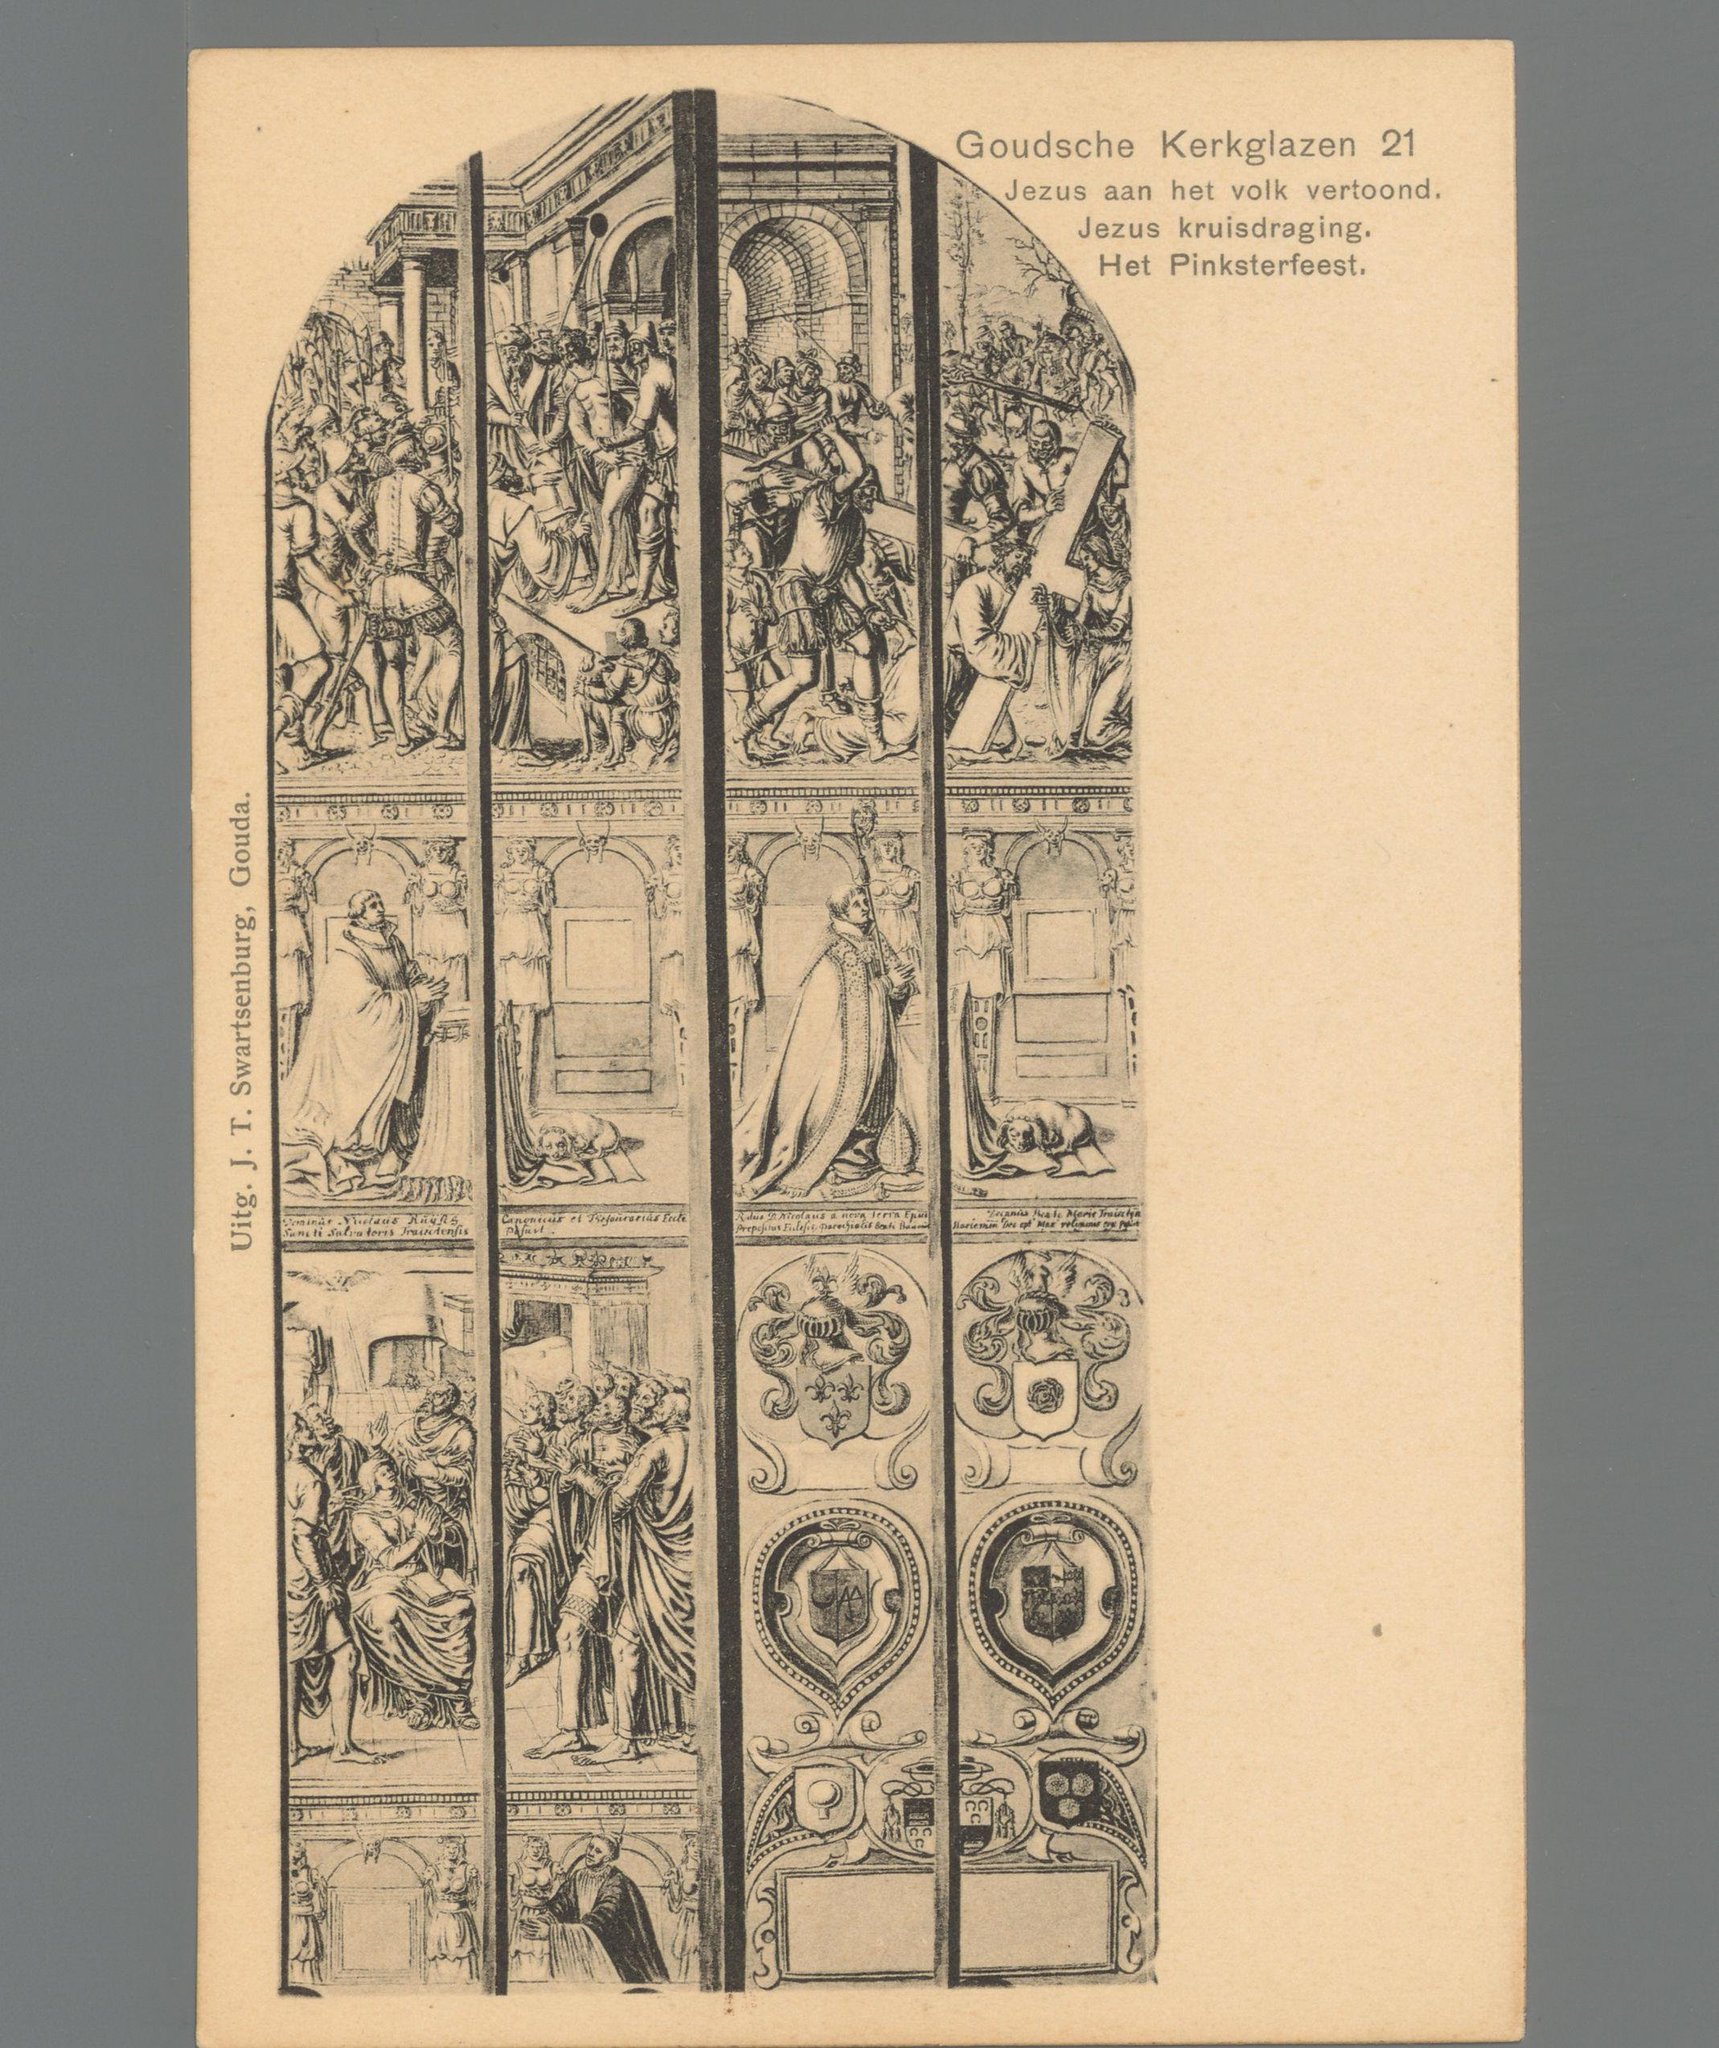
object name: ansichtkaart, prentbriefkaart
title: Jezus aan het volk vertoond. Jezus kruisdraging. Het Pinksterfeest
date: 1892-1905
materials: cardboard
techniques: photograph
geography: gouda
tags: church-window, e.g. rose-window, gouda